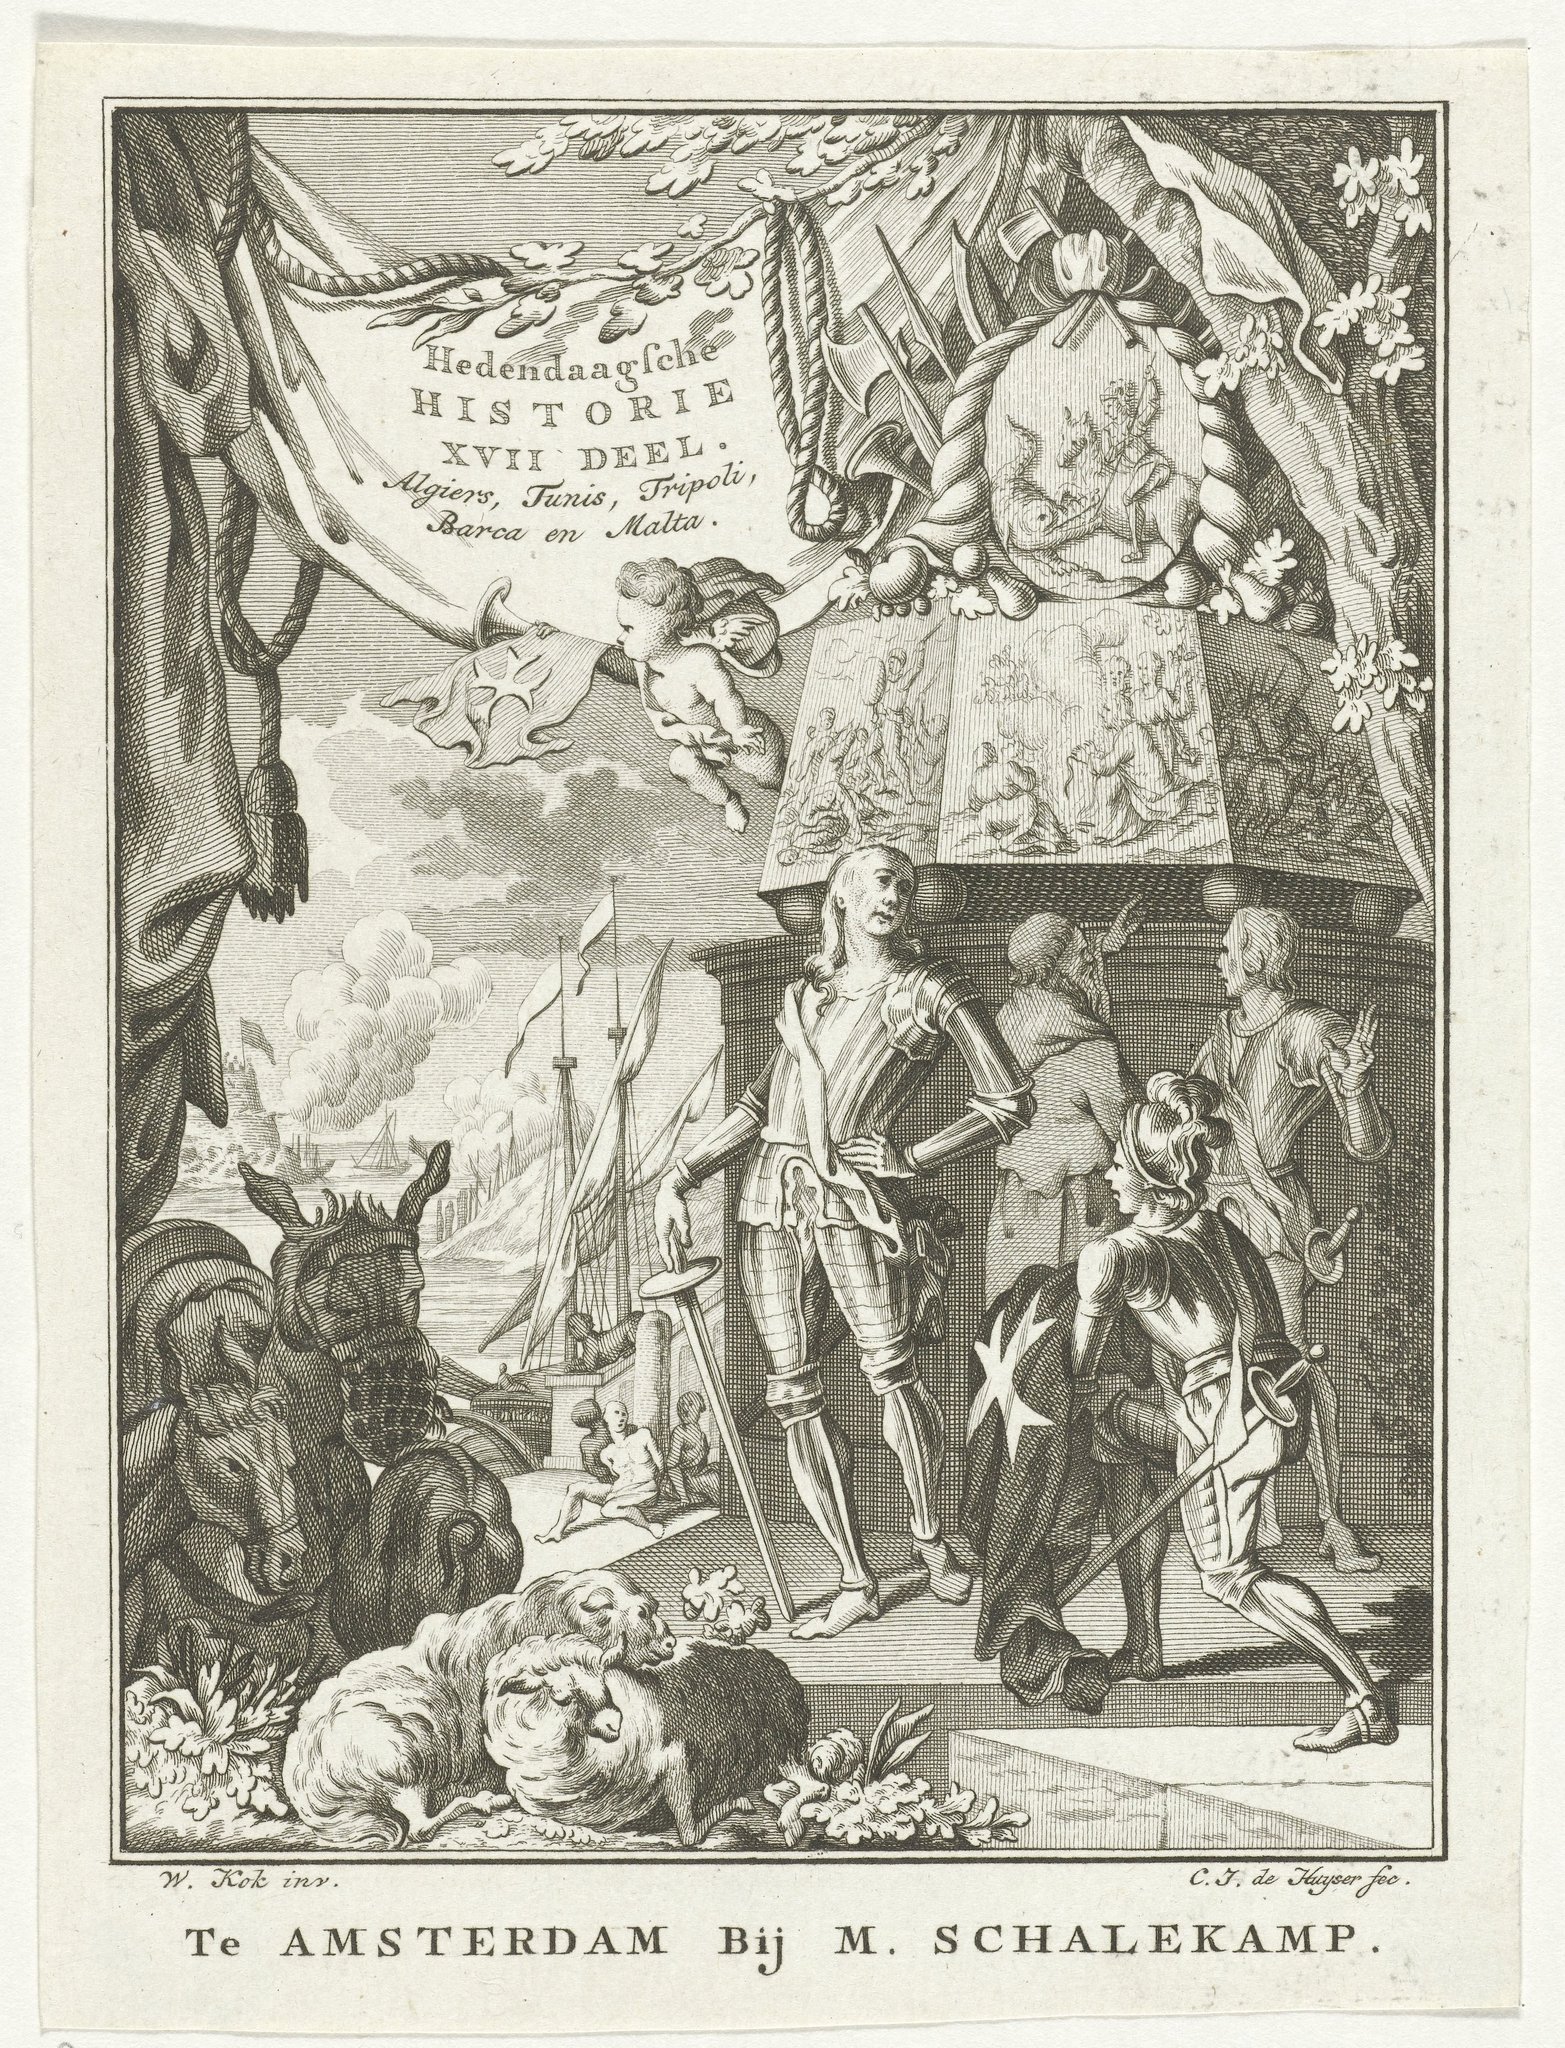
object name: titelblad, titelpagina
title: Allegorie op Noord-Afrika en Malta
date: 1786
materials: paper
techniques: engraving, etching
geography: amsterdam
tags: slavery; serfs and enslaved persons, military orders, e.g.: knights templars, knights of malta, teutonic knights ~ roman catholic church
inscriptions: collector's mark: Lugt 2228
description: Voor een monument, met daarop een afbeelding van Joris en de draak, een geharnaste man, die door een geknielde man een gewaad aangeboden krijgt met daarop het Maltezer kruis. Linksvoor twee ezels en twee schapen. Linksachter een schip en zee, met daarvoor vastgebonden tot slaaf gemaakte mannen.